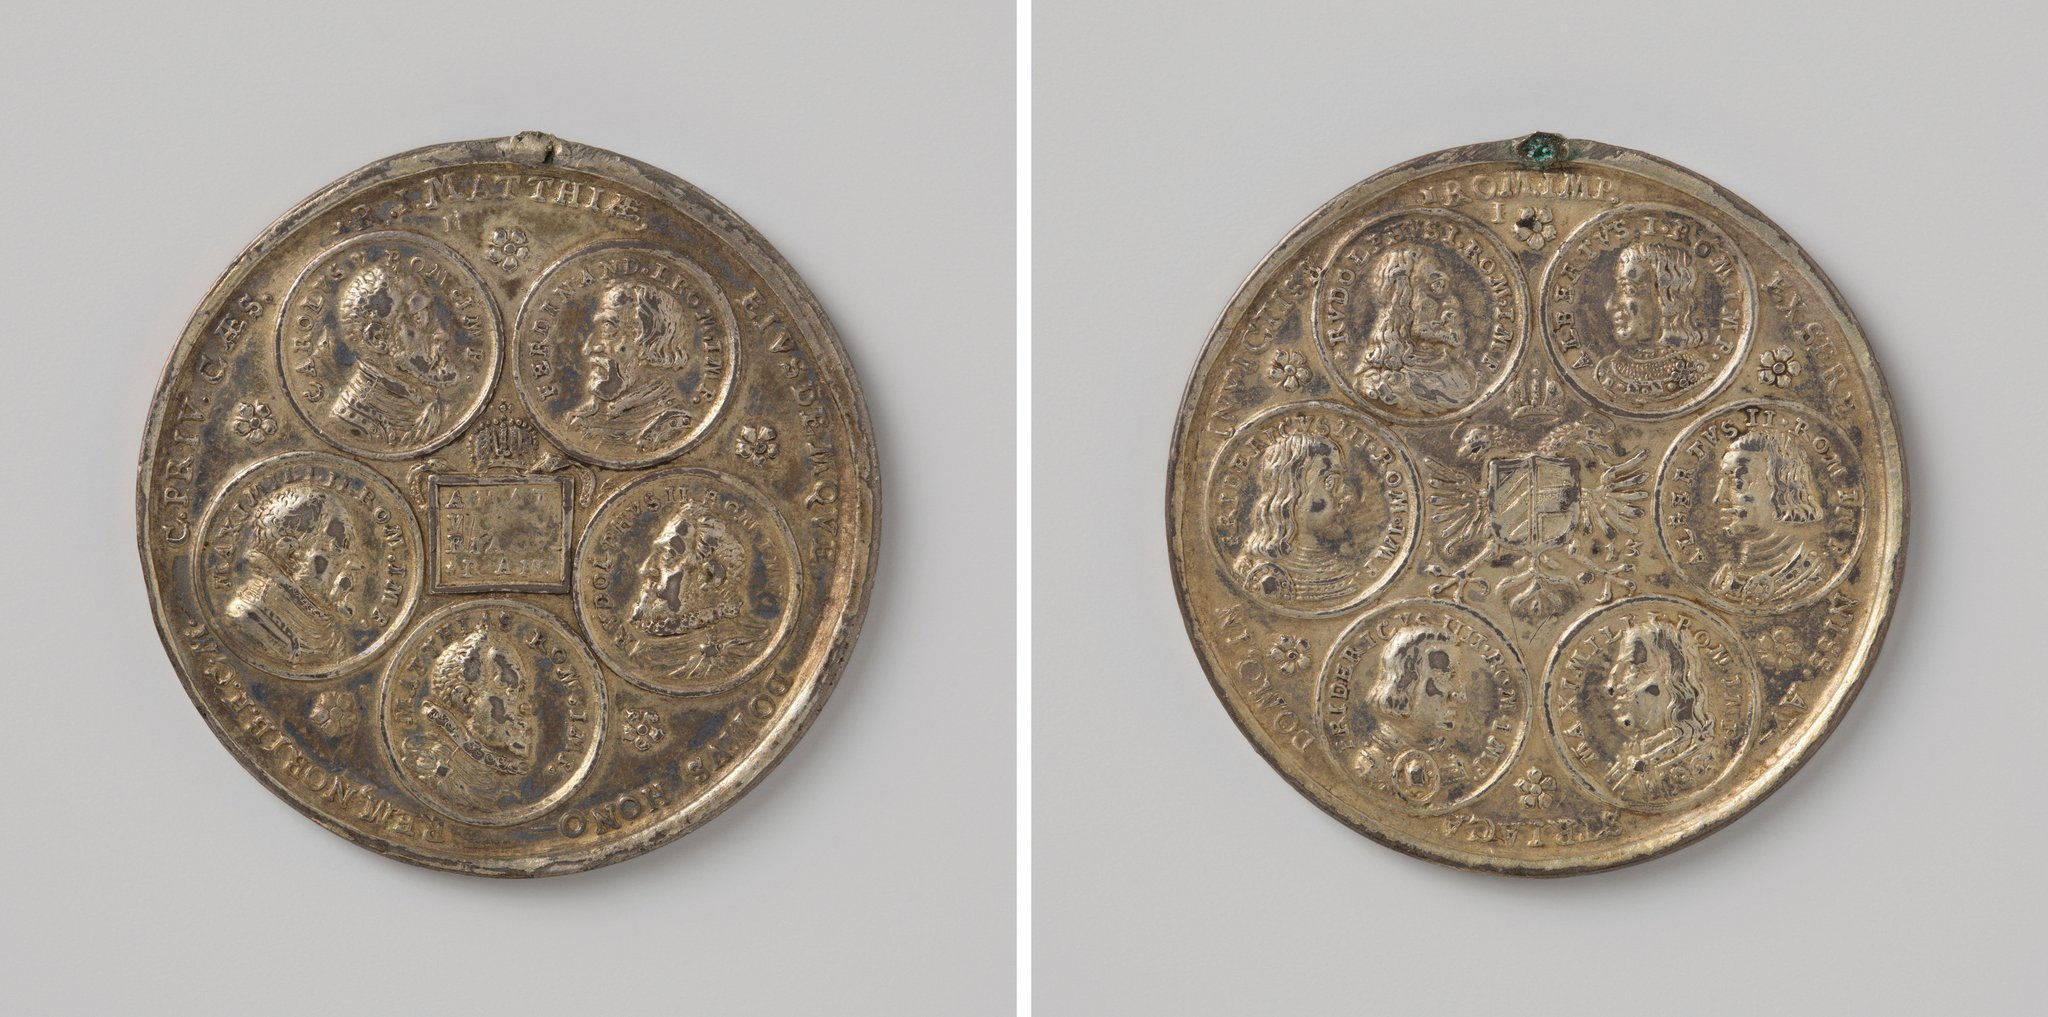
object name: history medal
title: Kroning van keizer Matthias, afkomstig uit een edel geslacht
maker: christian maler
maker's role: medailleur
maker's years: 1578-1652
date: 1613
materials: copper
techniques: striking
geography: gotha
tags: matthias van oostenrijk (rooms-duits keizer), maximilian i (holy roman emperor), charles v (holy roman emperor and king of spain), ferdinand i van habsburg (duits keizer), vienna, maximiliaan ii (keizer van heilige roomse rijk), rudolf ii van habsburg (duits keizer)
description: Koperen penning. Voorzijde: vijf portretmedailles van Duitse keizers (Karel V, Ferdinand I, Rudolf II, Matthias, Maximiliaan II) binnen omschrift. Keerzijde: zes portetmedailles van Duitse keizers (Rudolf I, Albert I, Albert II, Maximiliaan I, Frederik IIII, Frederik III) met daartussen wapen van Oosterijk binnen omschrift.